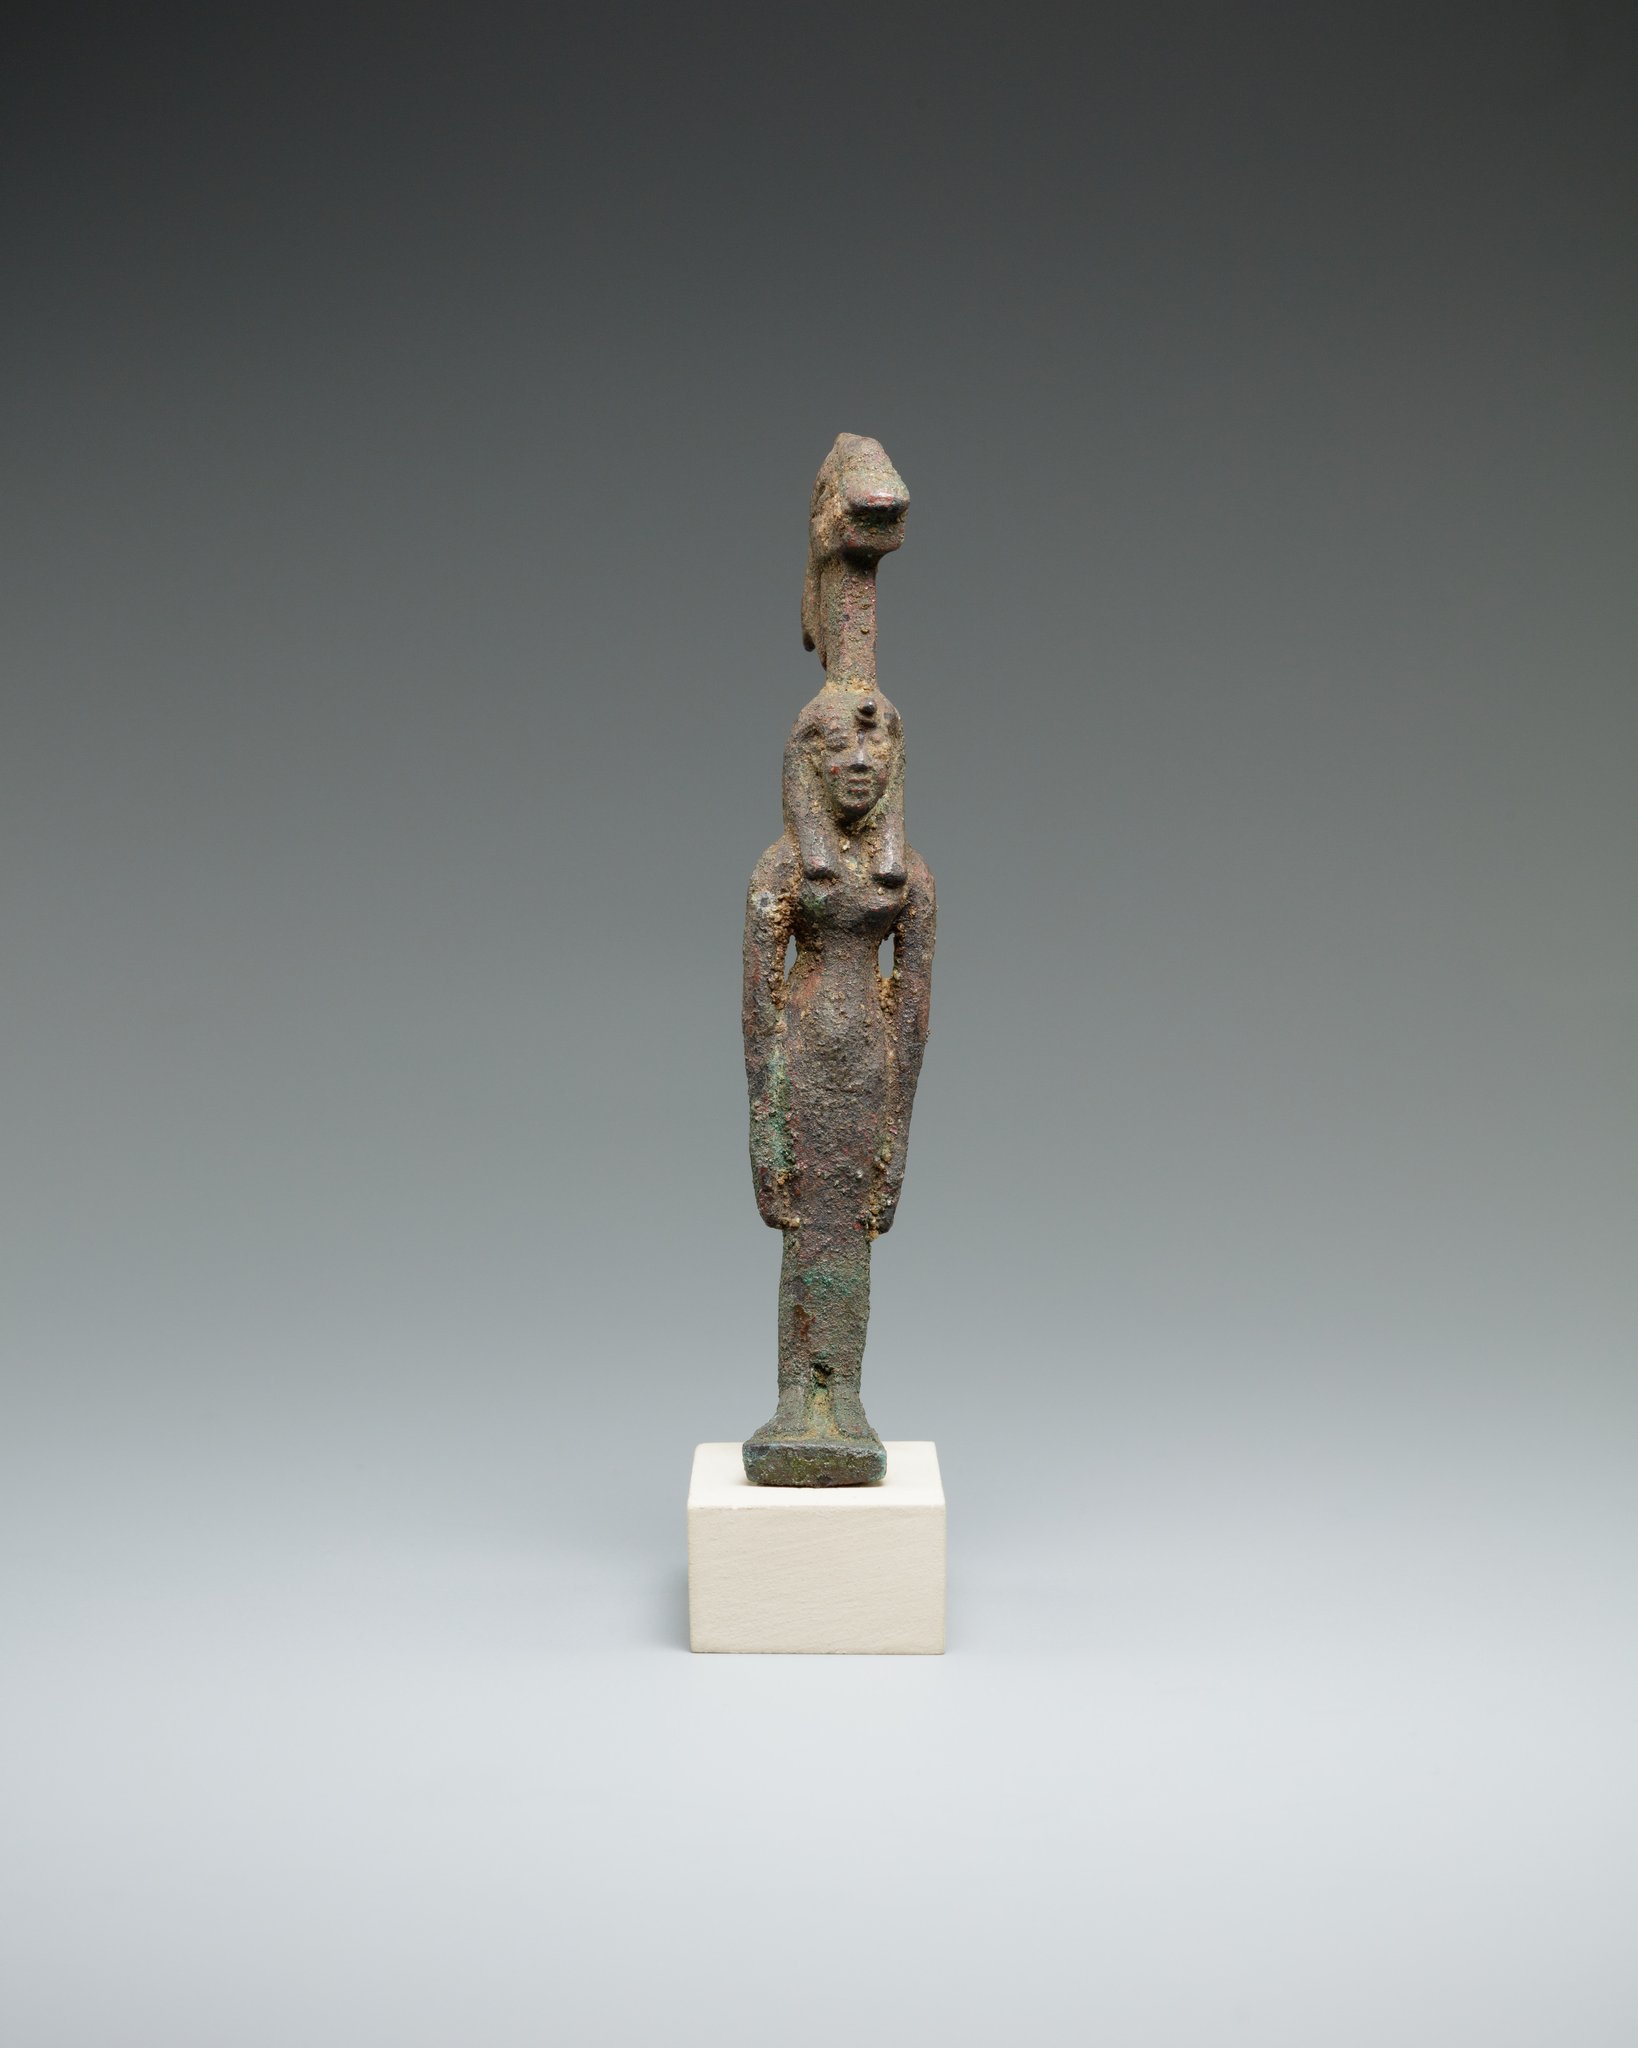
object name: statuette, hatmehyt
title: Hatmehyt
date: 664-630 BCE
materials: alloy, bronze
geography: eastern delta